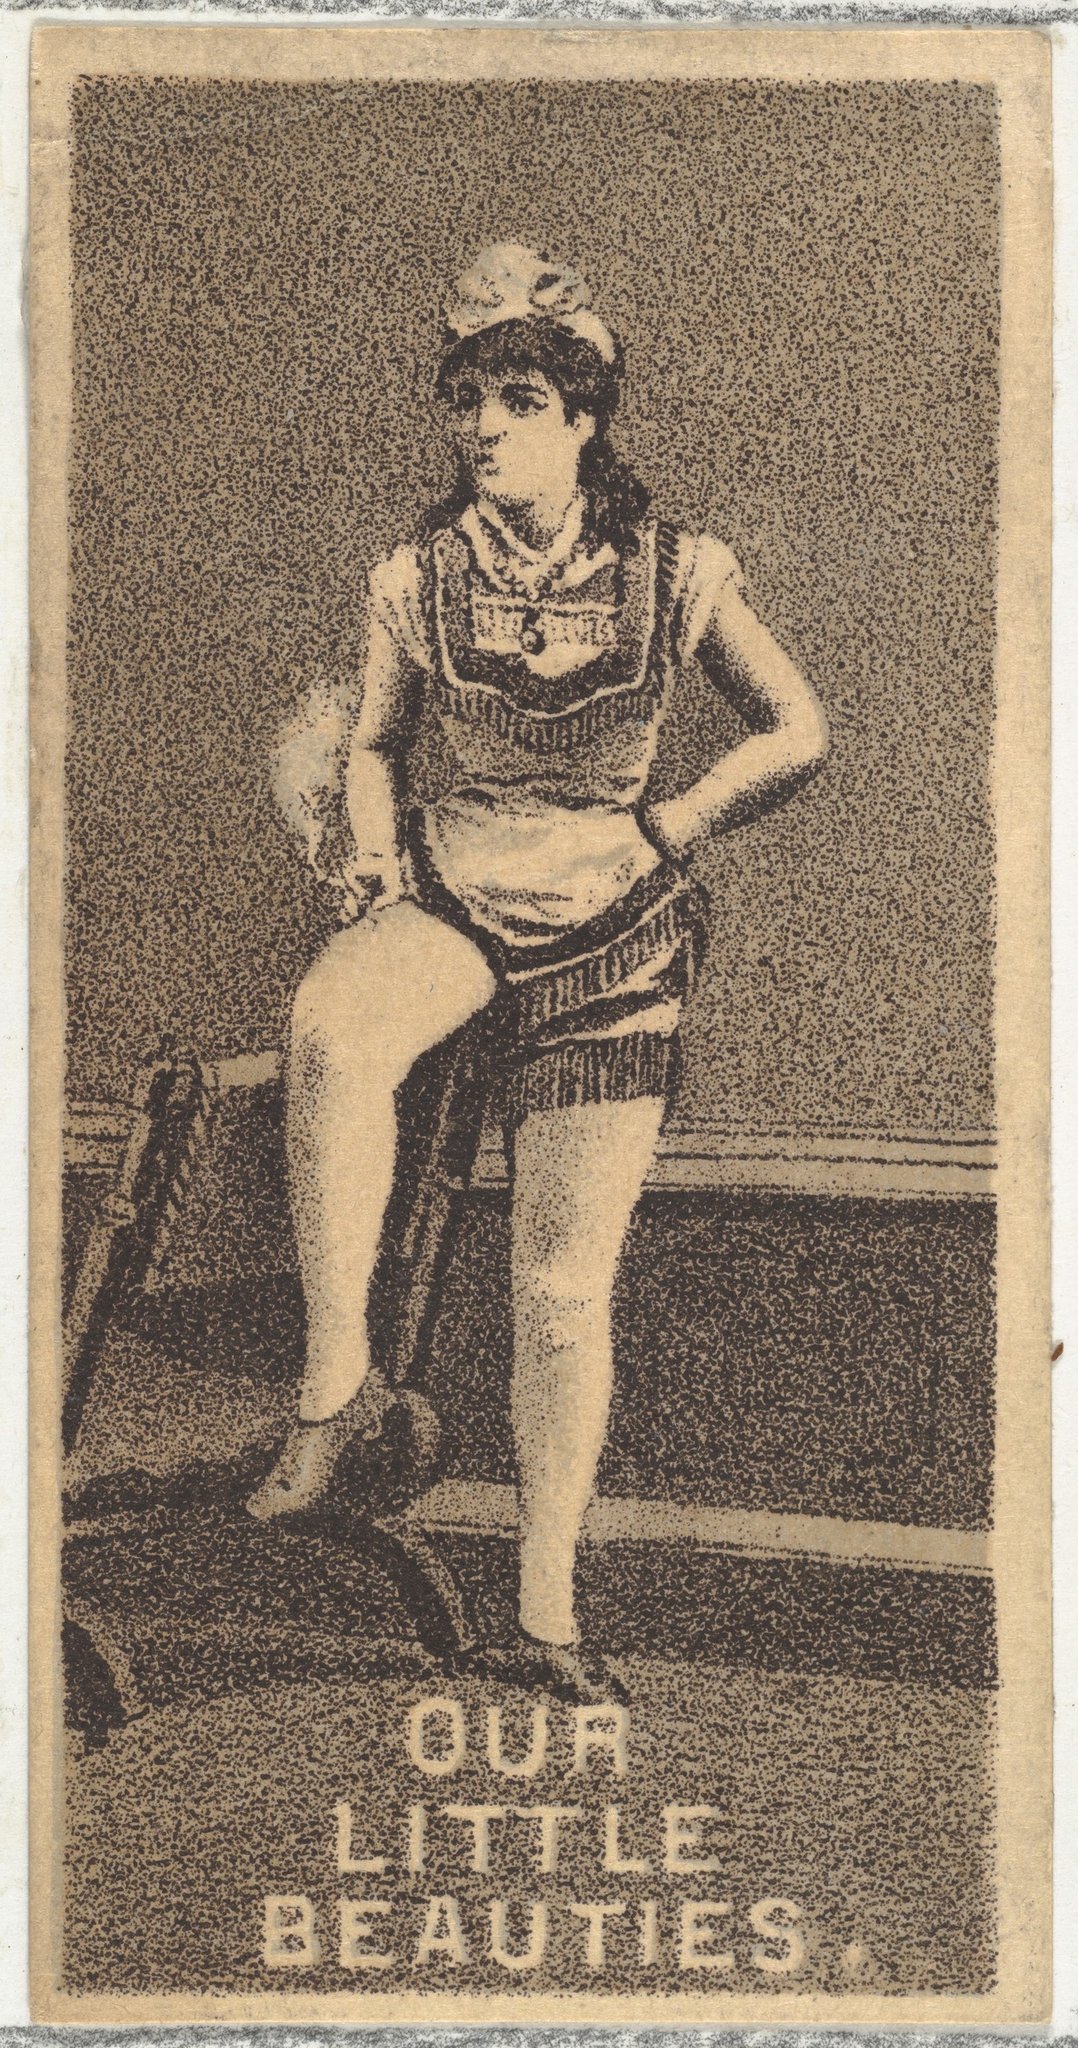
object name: print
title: From the Actresses series (N57) promoting Our Little Beauties Cigarettes for Allen & Ginter brand tobacco products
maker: allen & ginter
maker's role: publisher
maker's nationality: american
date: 1890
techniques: photolithograph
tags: portraits,women,actresses